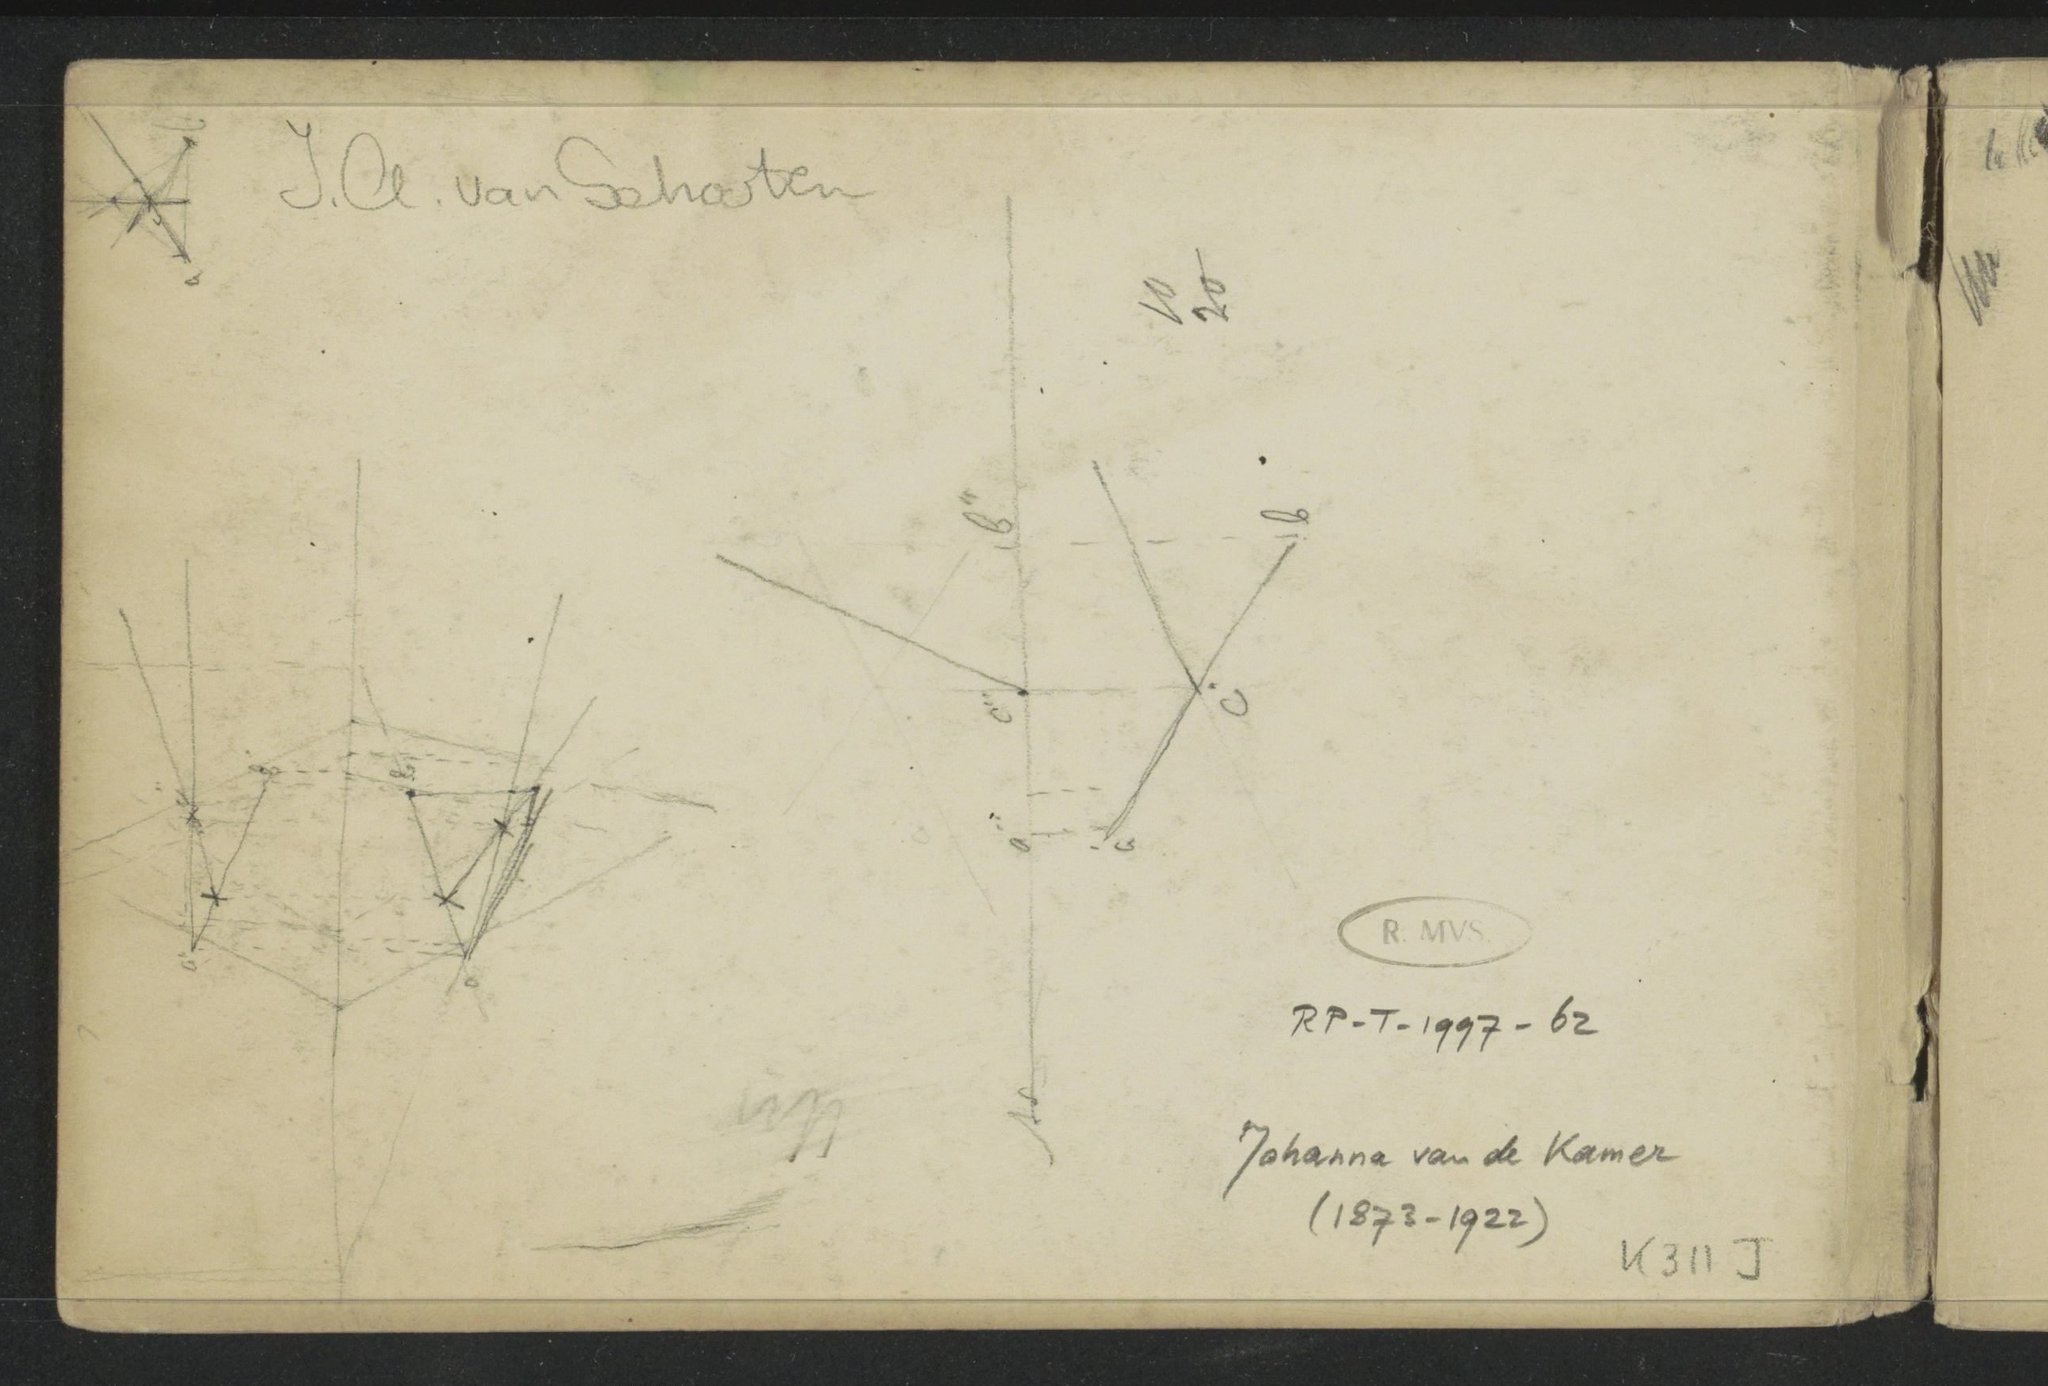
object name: endleaf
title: Perspectiefoefeningen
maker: johanna van de kamer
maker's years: 1873-1922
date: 1883-1922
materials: paper, pencil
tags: mathematical perspective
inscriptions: collector's mark: Lugt 2228a, name: ‘I.A. van Schooten’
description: Voorste schutblad uit een schetsboek met 13 bladen.